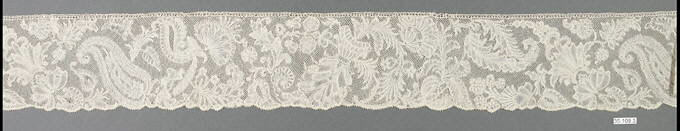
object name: border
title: Border (one of three)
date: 1701-1800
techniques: lace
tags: flowers